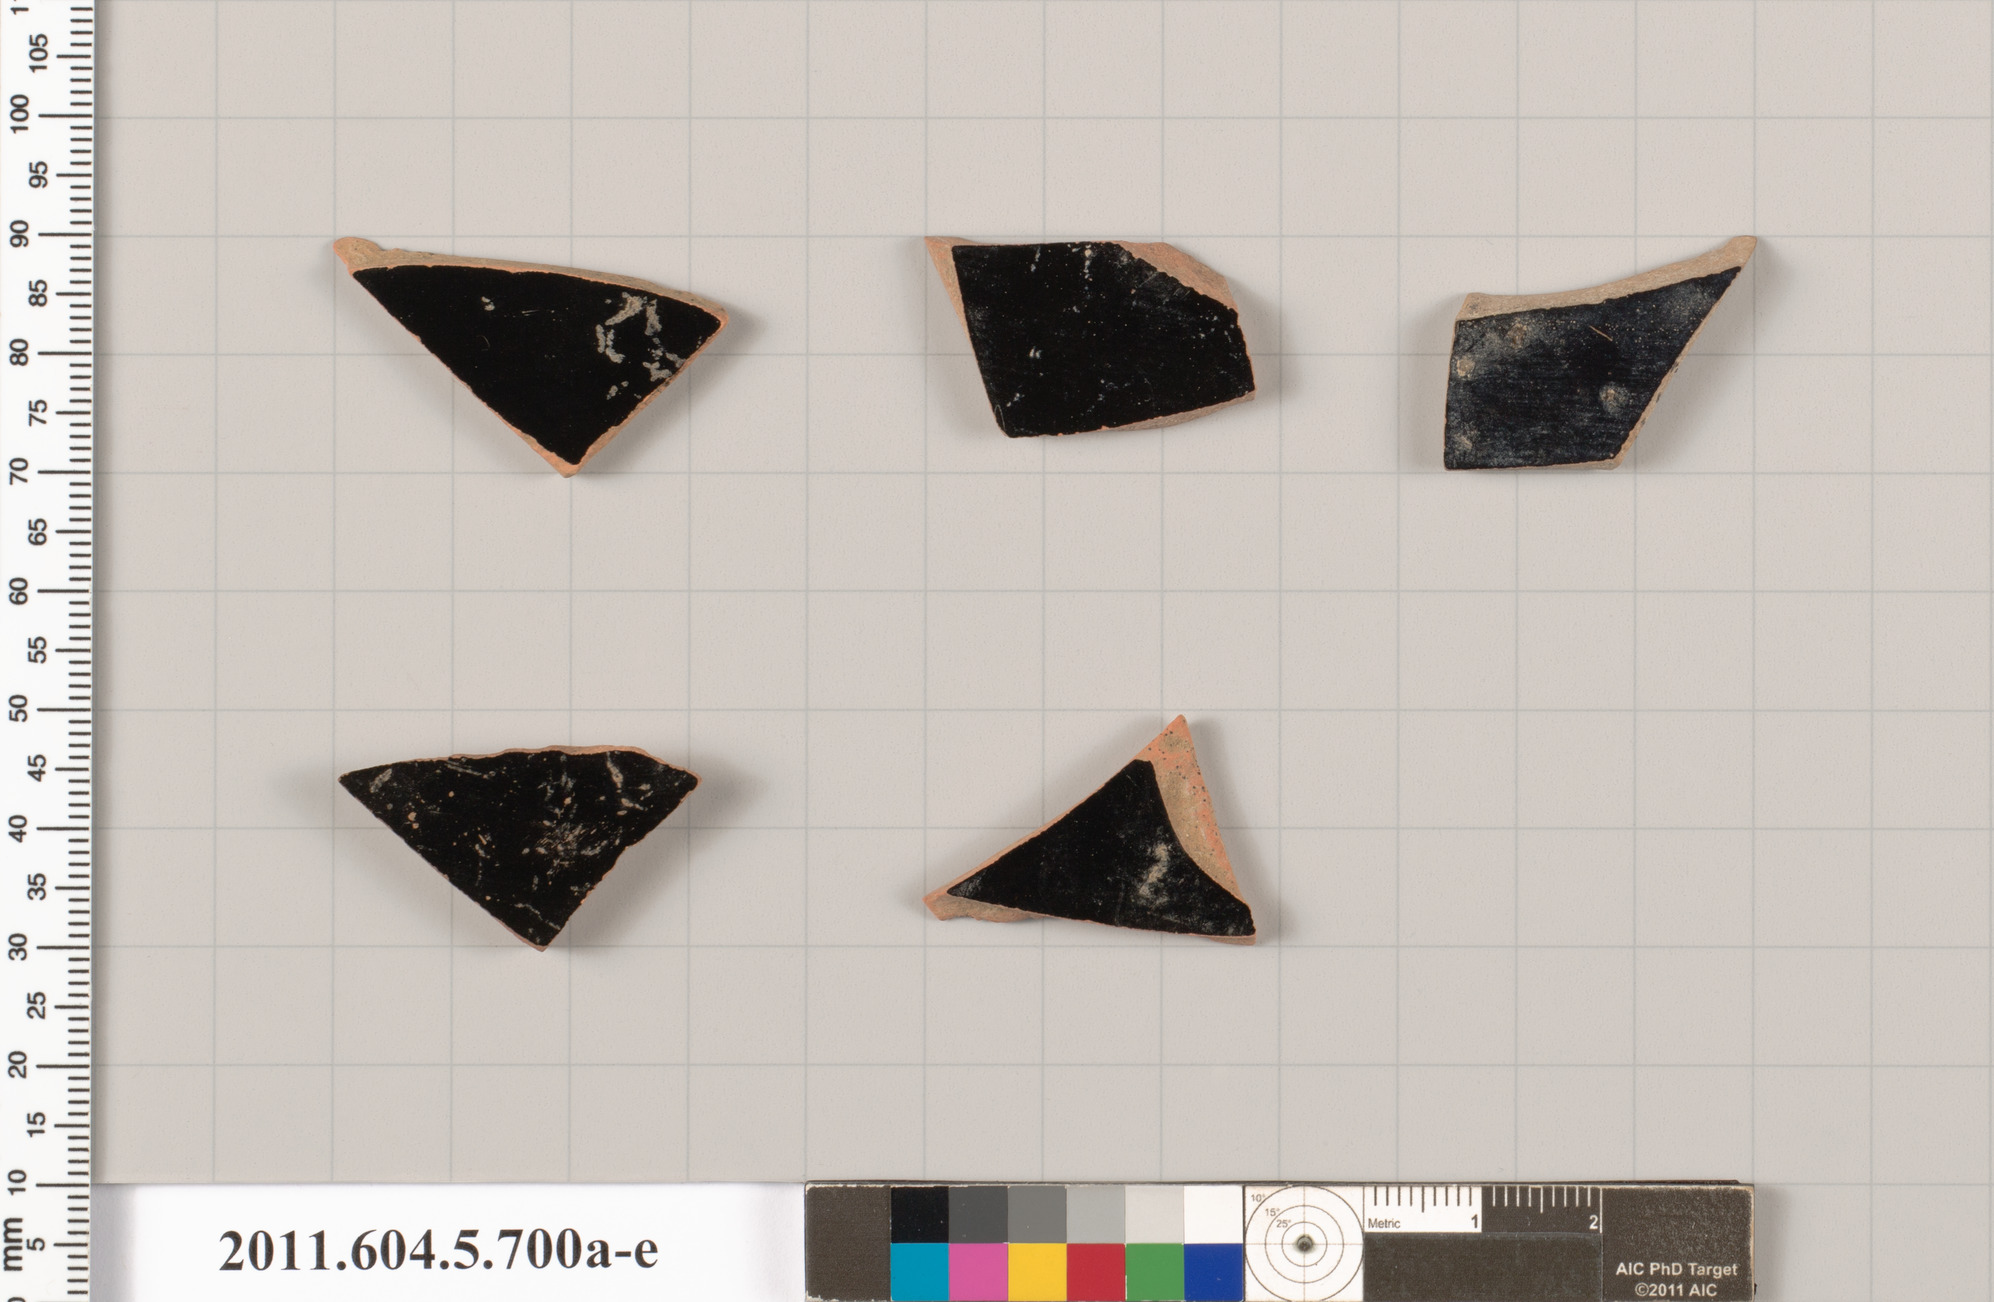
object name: kylix fragment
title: Terracotta fragments of kylikes (drinking cups)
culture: greek, attic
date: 600-401 BCE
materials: terracotta